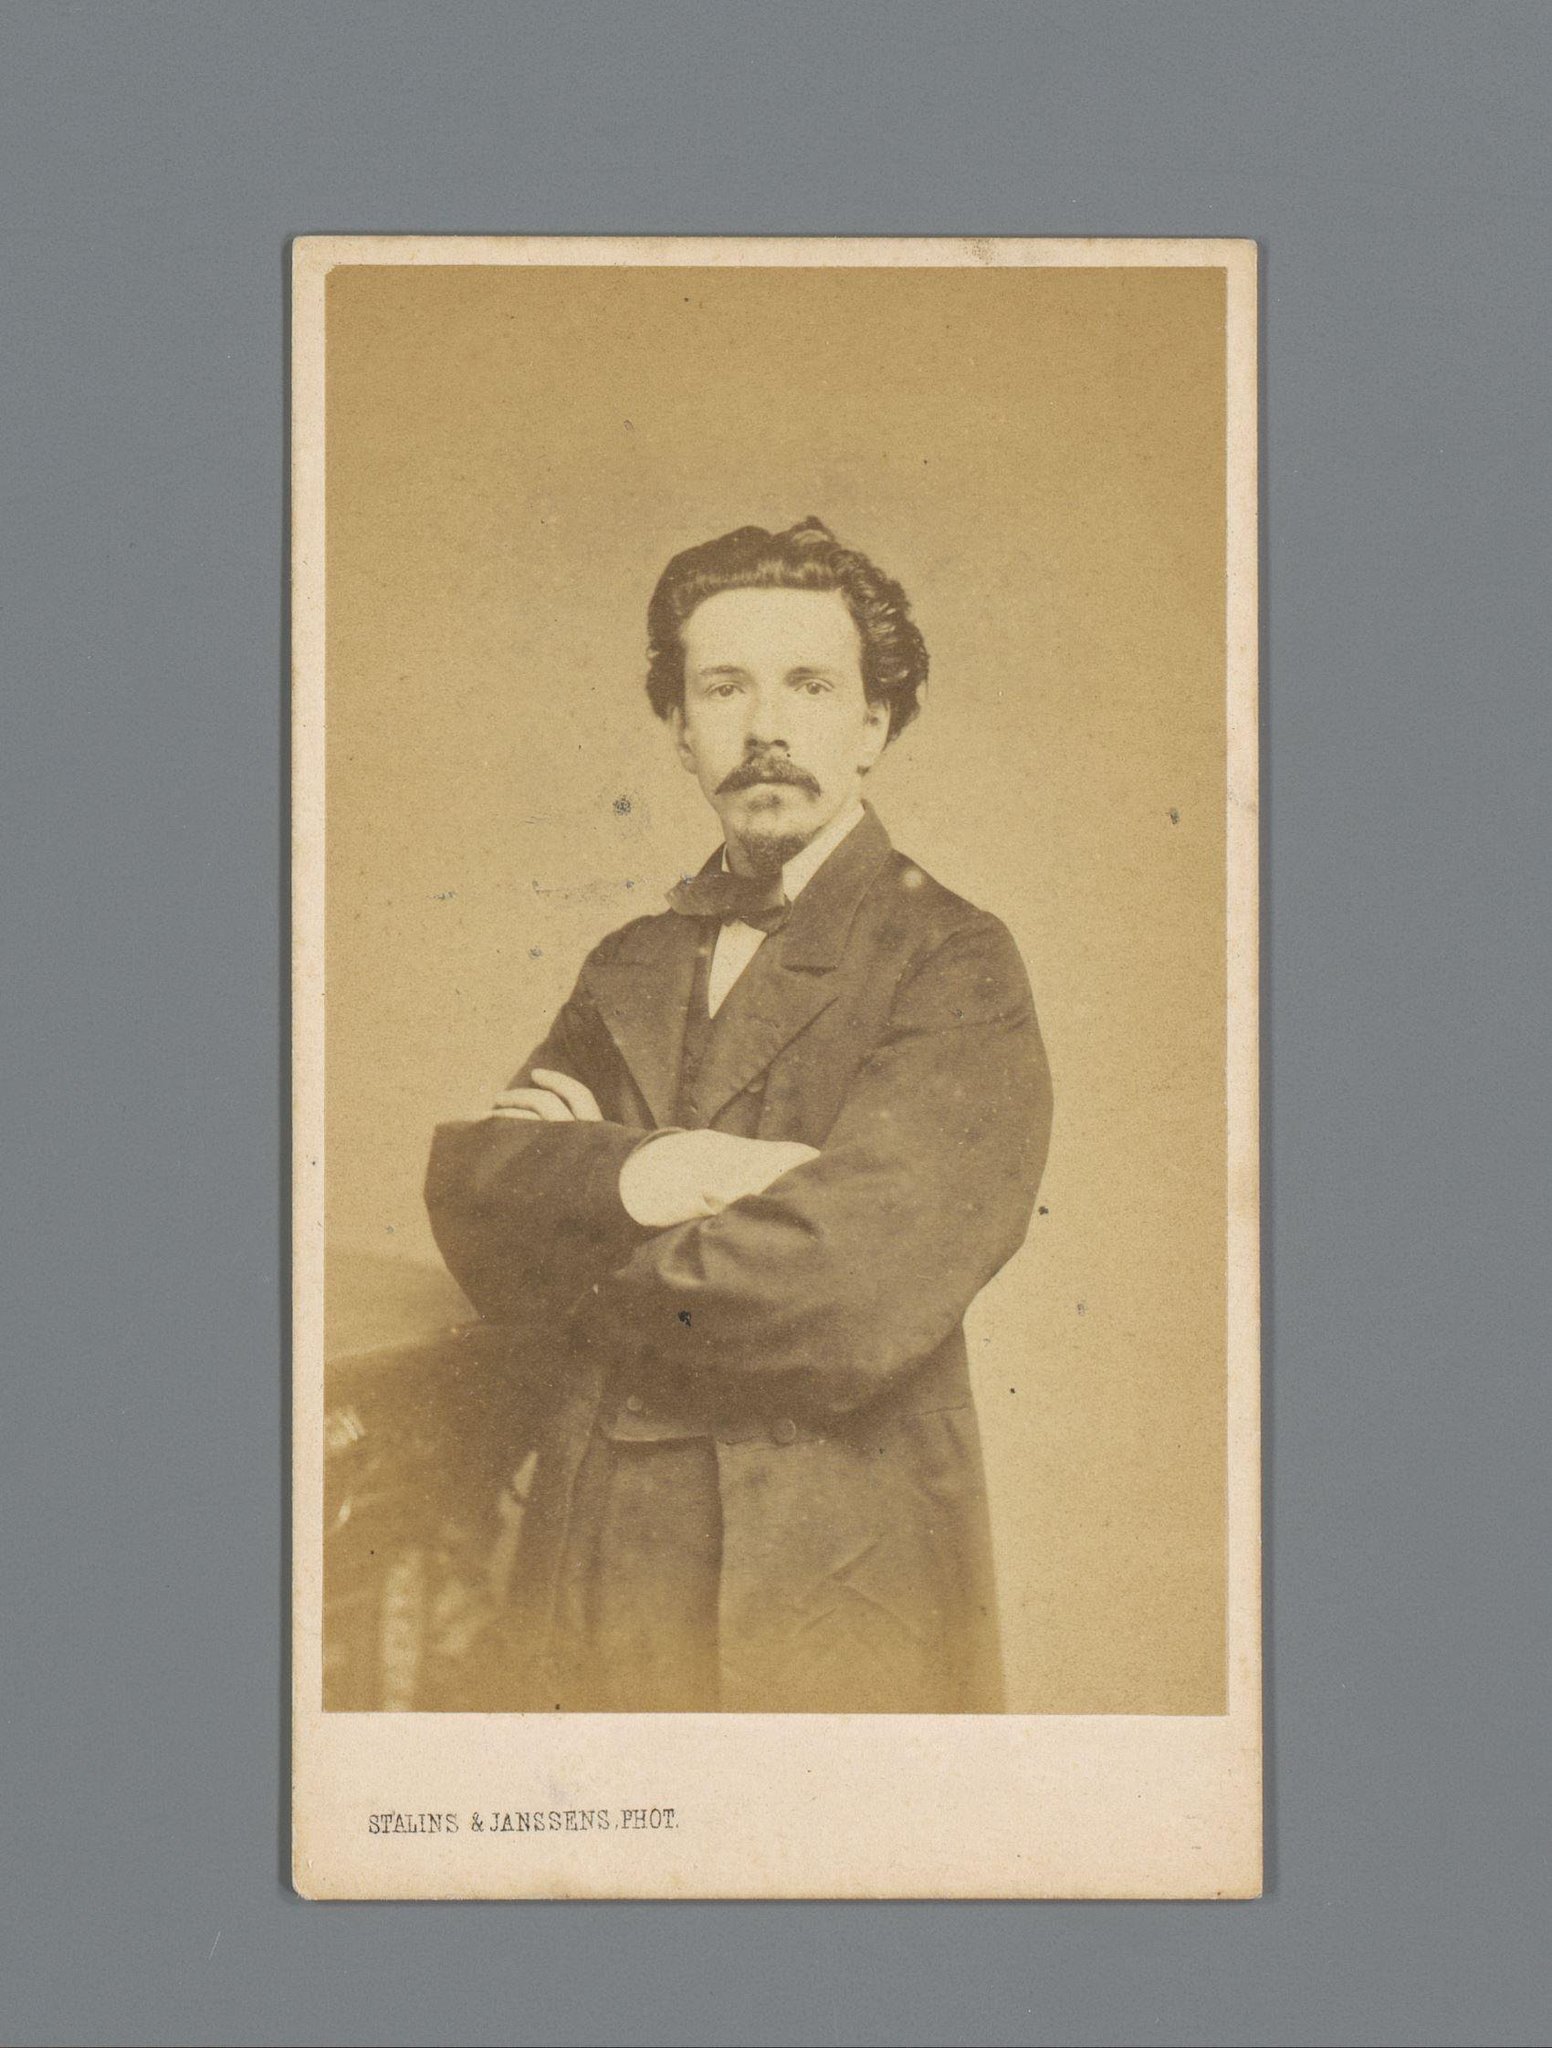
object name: photograph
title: Portret van de schilder Pierre Jean Van der Ouderaa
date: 1866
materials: cardboard, paper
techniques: albumen print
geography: antwerp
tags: antwerp, painter, pierre jean van der ouderaa, historical persons, portrait, self-portrait of painter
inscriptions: inscription: ‘(peintre)/ 1841-1915/ A'pen’, inscription: ‘Piet Van der Ouderaa/ 1866.’, inscription: ‘Etablissement Photographique/ de/ Stalins & Janssens/ 38, Rempart du Lombard, 38/ Anvers.’, inscription: ‘Stalins & Janssens, Phot.’